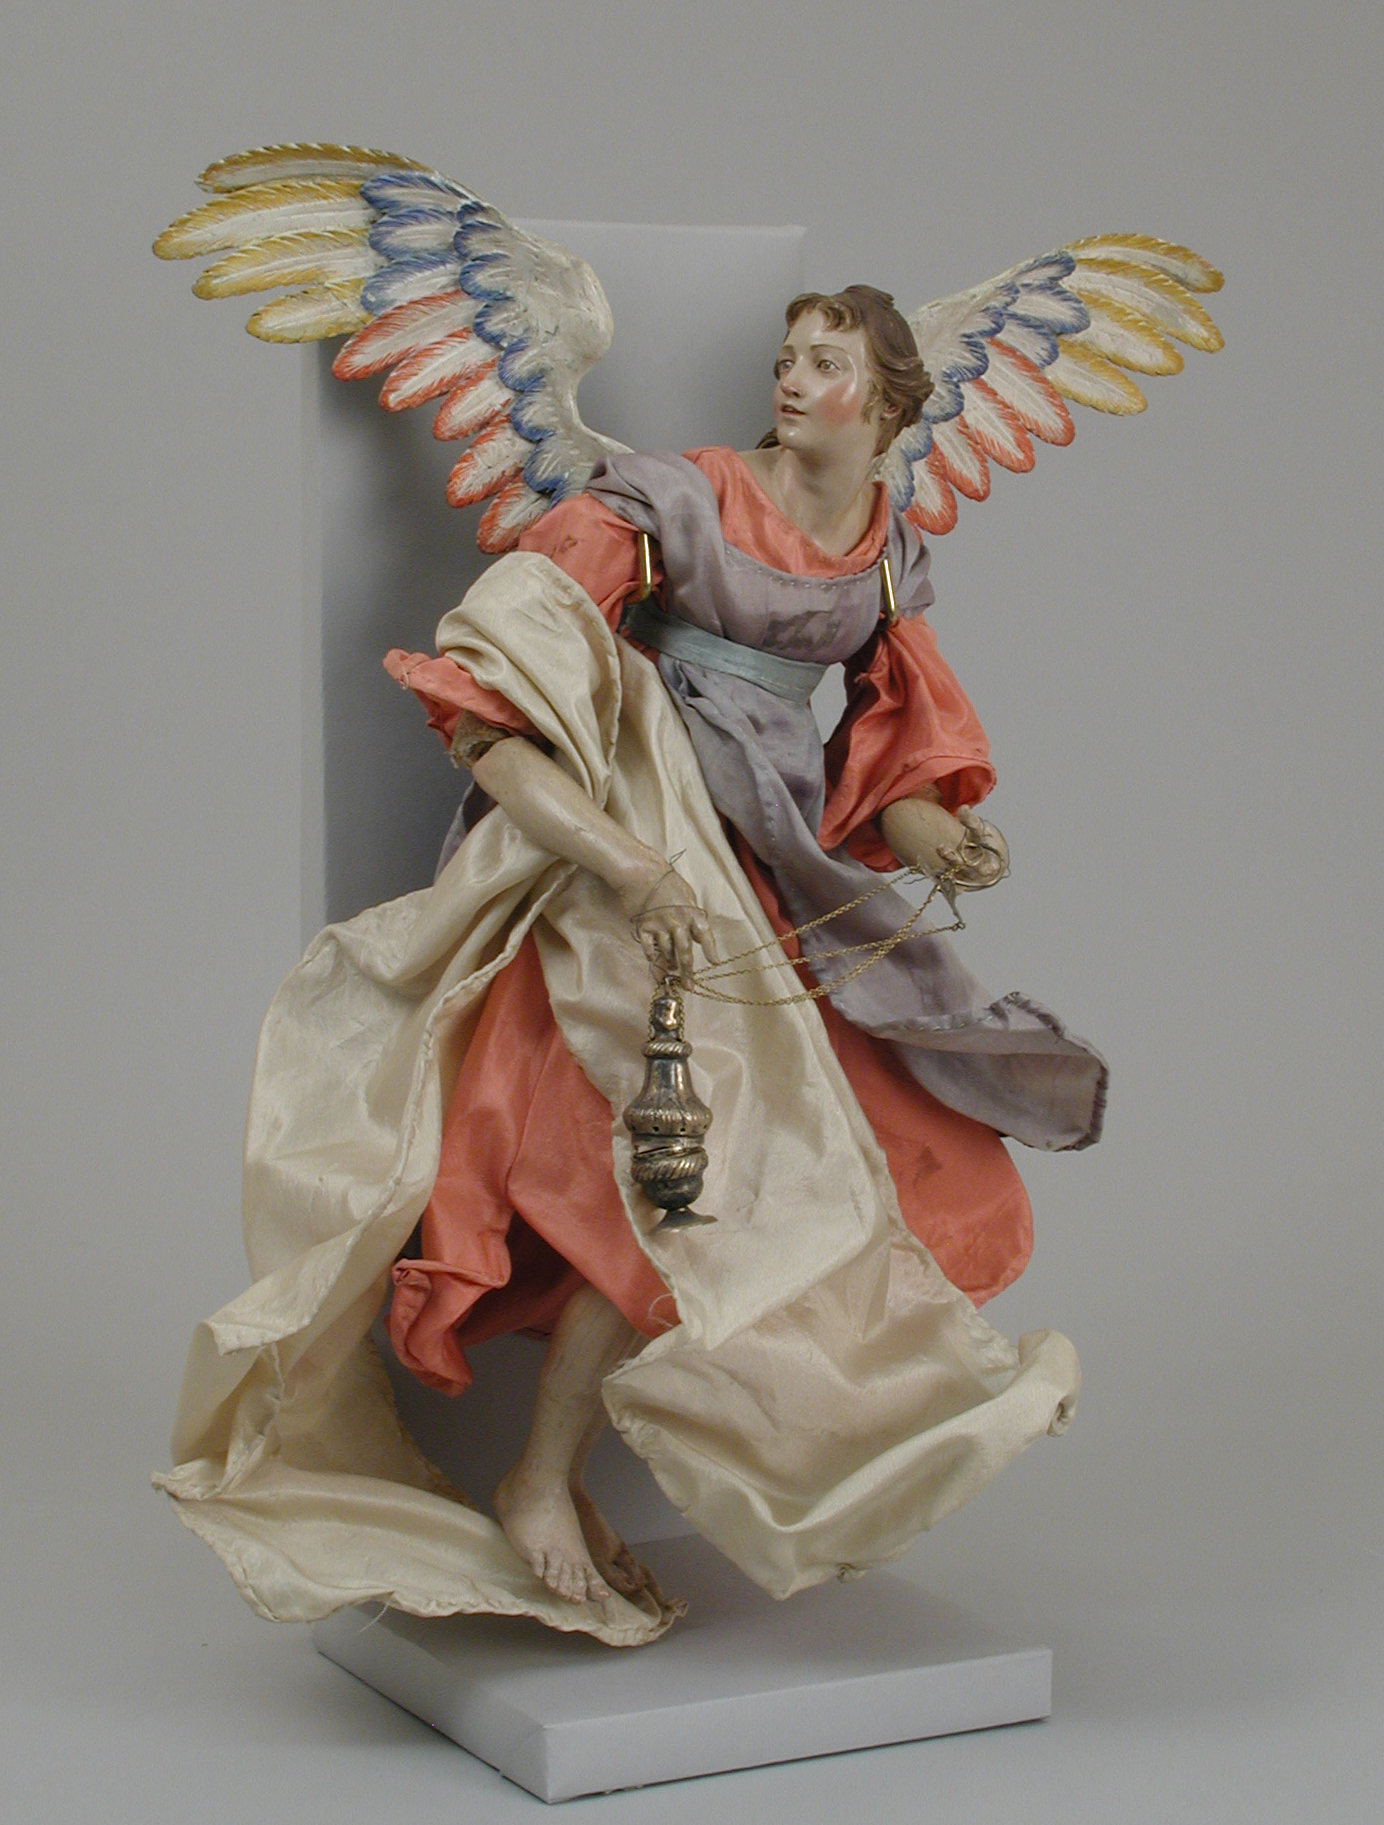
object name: crèche figure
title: Angel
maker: lorenzo mosca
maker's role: maker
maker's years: 1689-1789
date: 1701-1800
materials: terracotta, fiber, metal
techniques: polychrome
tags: angels,censers